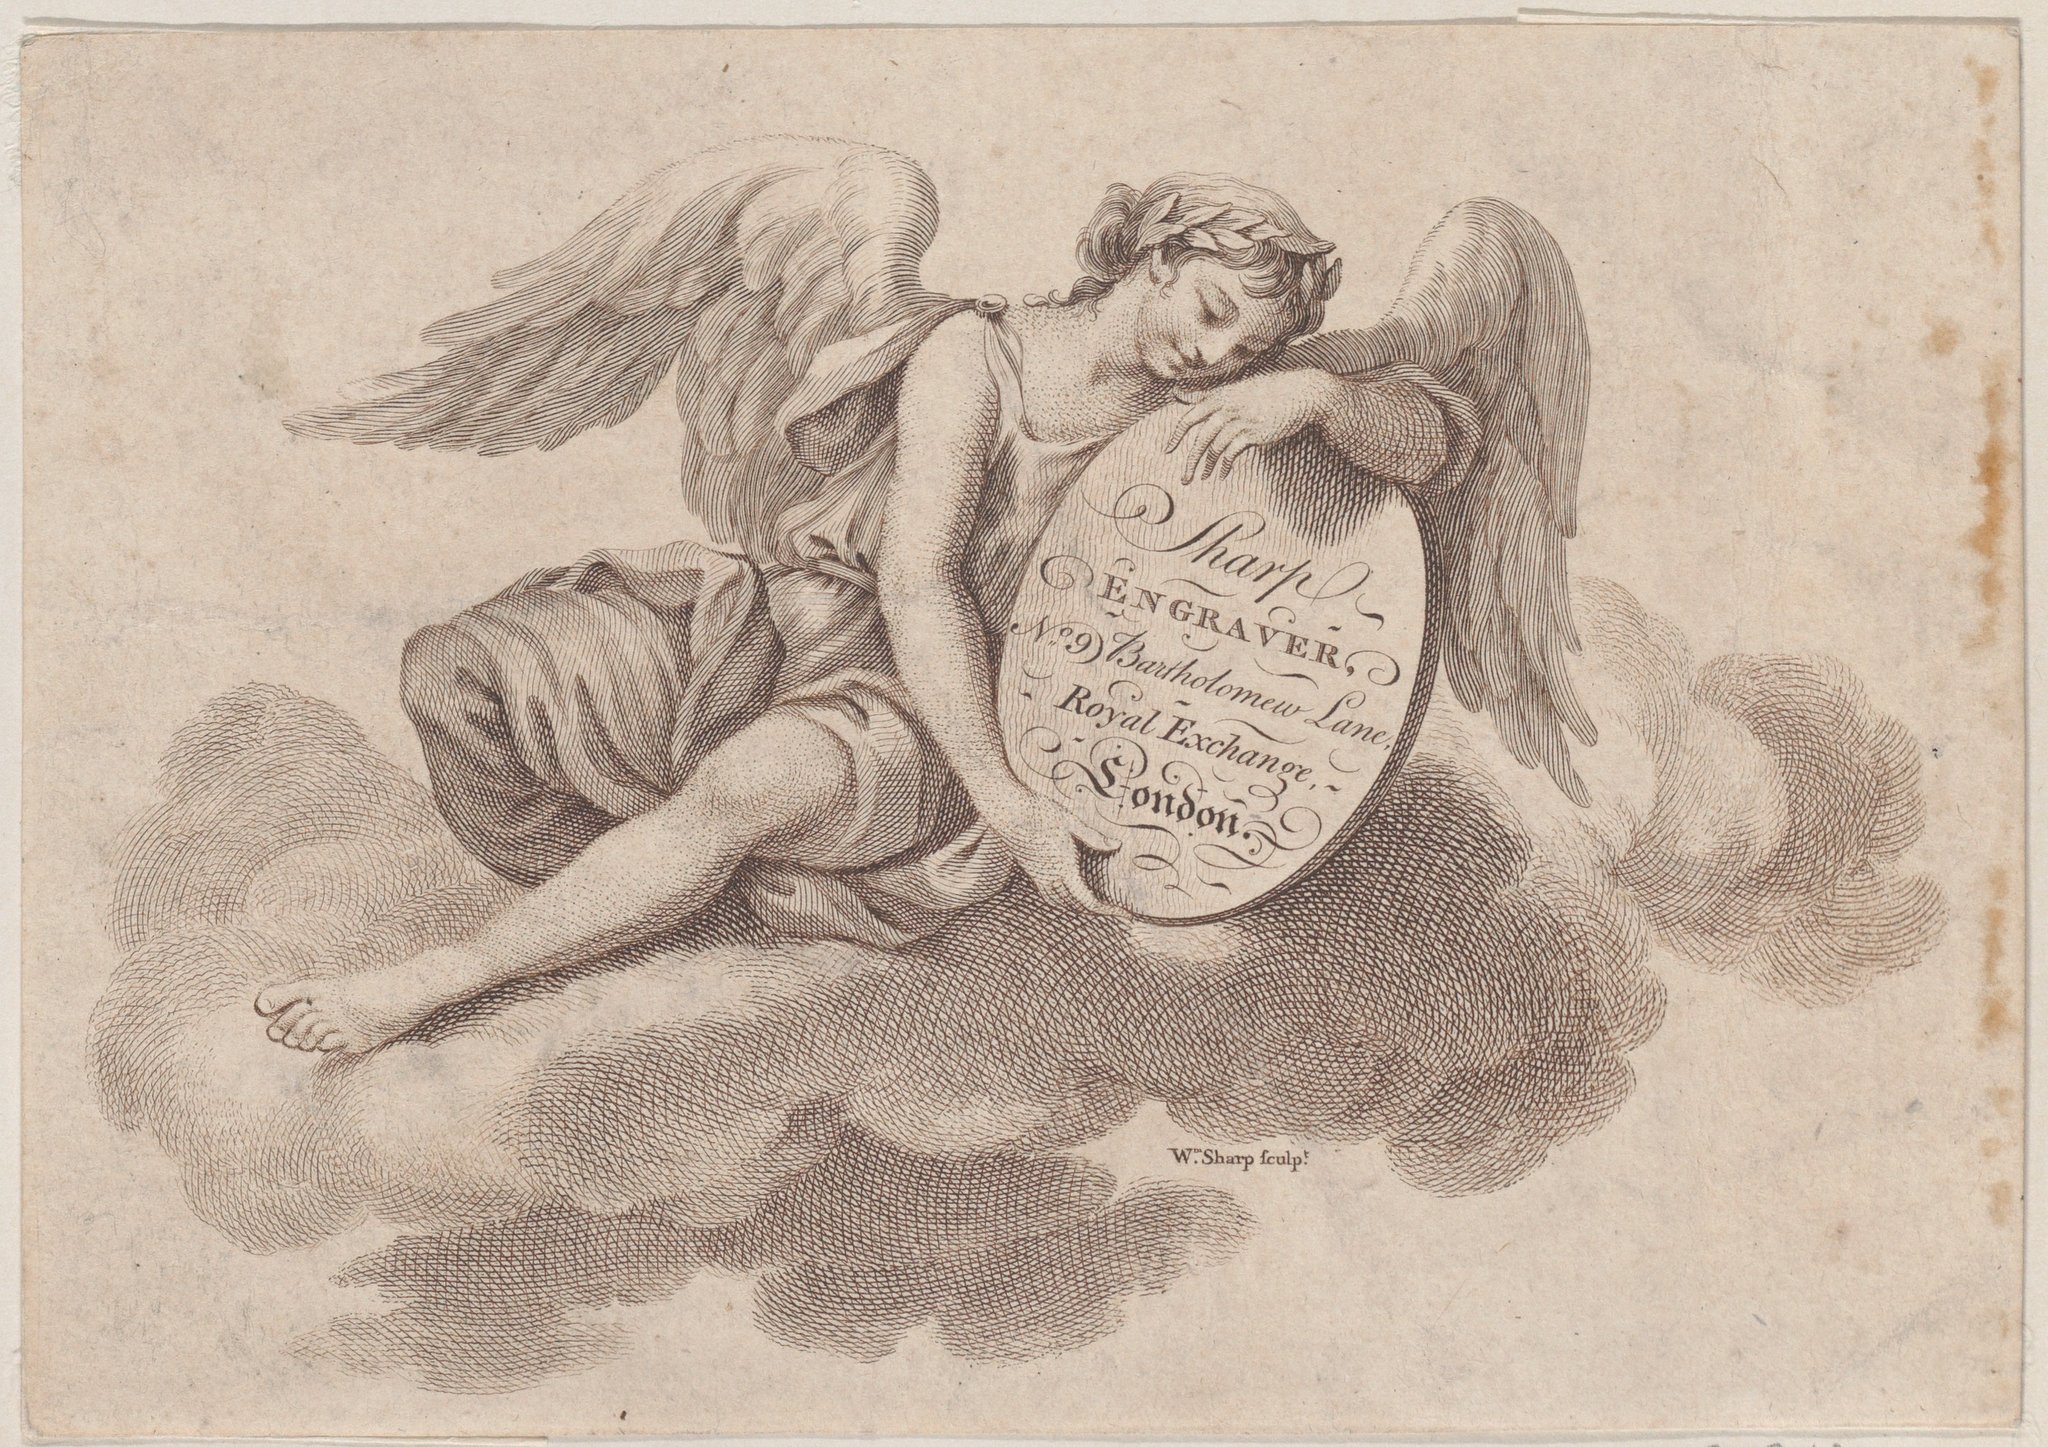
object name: print, trade card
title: Trade Card for William Sharp, Engraver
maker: william sharp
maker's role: artist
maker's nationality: british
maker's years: 1749-1824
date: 1701-1800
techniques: engraving